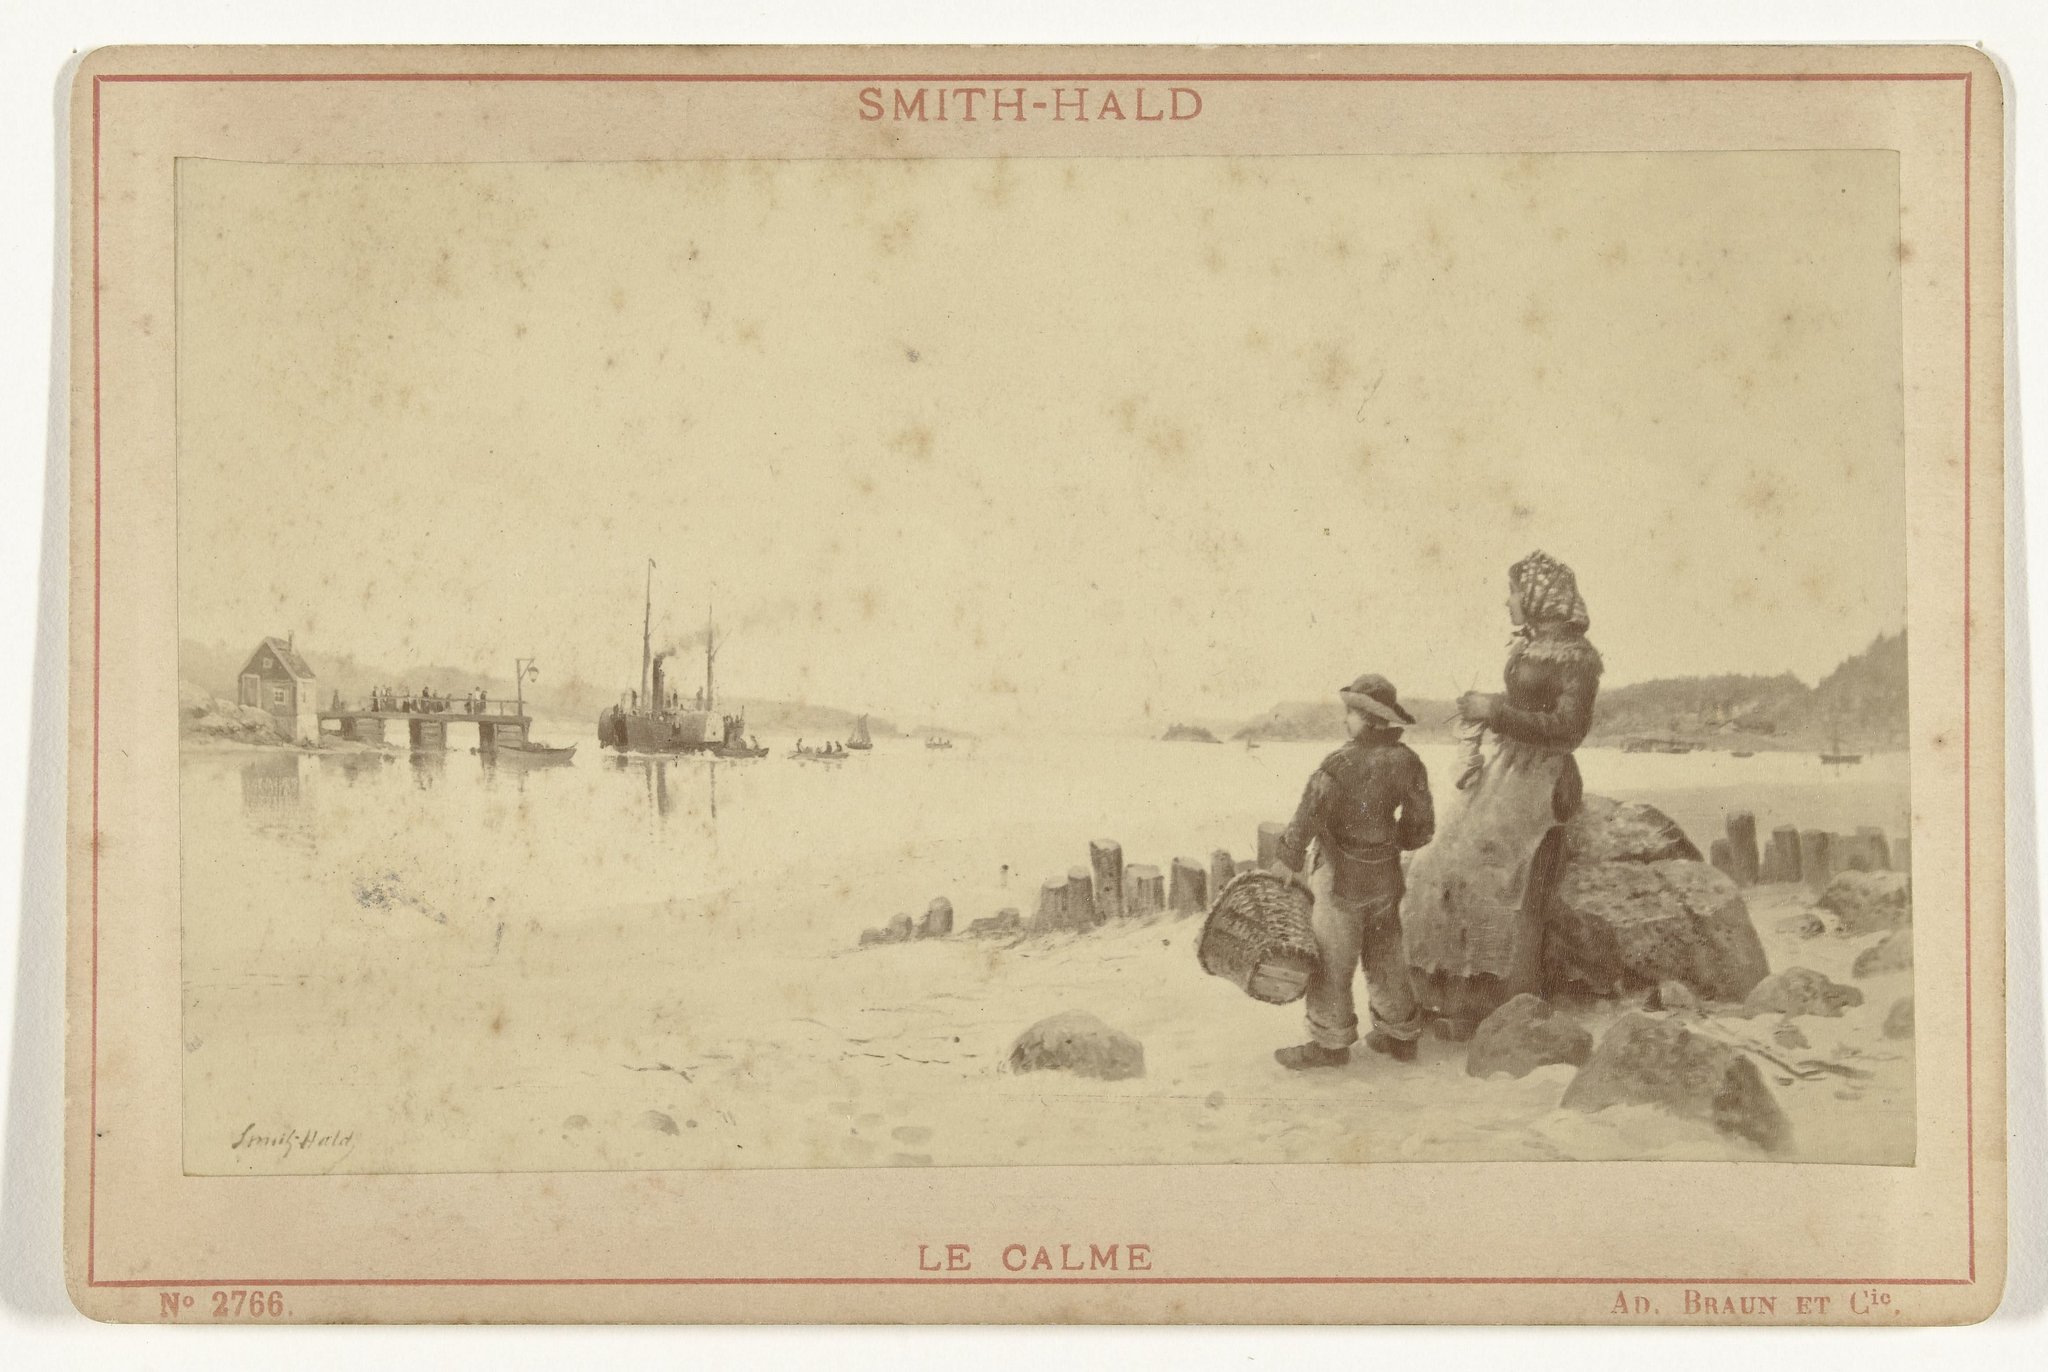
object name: reproduction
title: Le Calme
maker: frithjof smith-hald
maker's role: painter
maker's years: 1846-1903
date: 1866-1889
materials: cardboard, paper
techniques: albumen print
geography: dornach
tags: sea (seascape)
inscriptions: annotation: ‘LE MÊME SUJET/ EN GRAND FORMAT/ Tiré au charbon, procédé inaltérable/ 15 francs.’, number: ‘No 2766.’, collector's mark: ‘VOSMAER’, address: ‘Ad. Braun et Cie, Dornach (Alsace); Avenue de l'Opera, 43, Paris.’